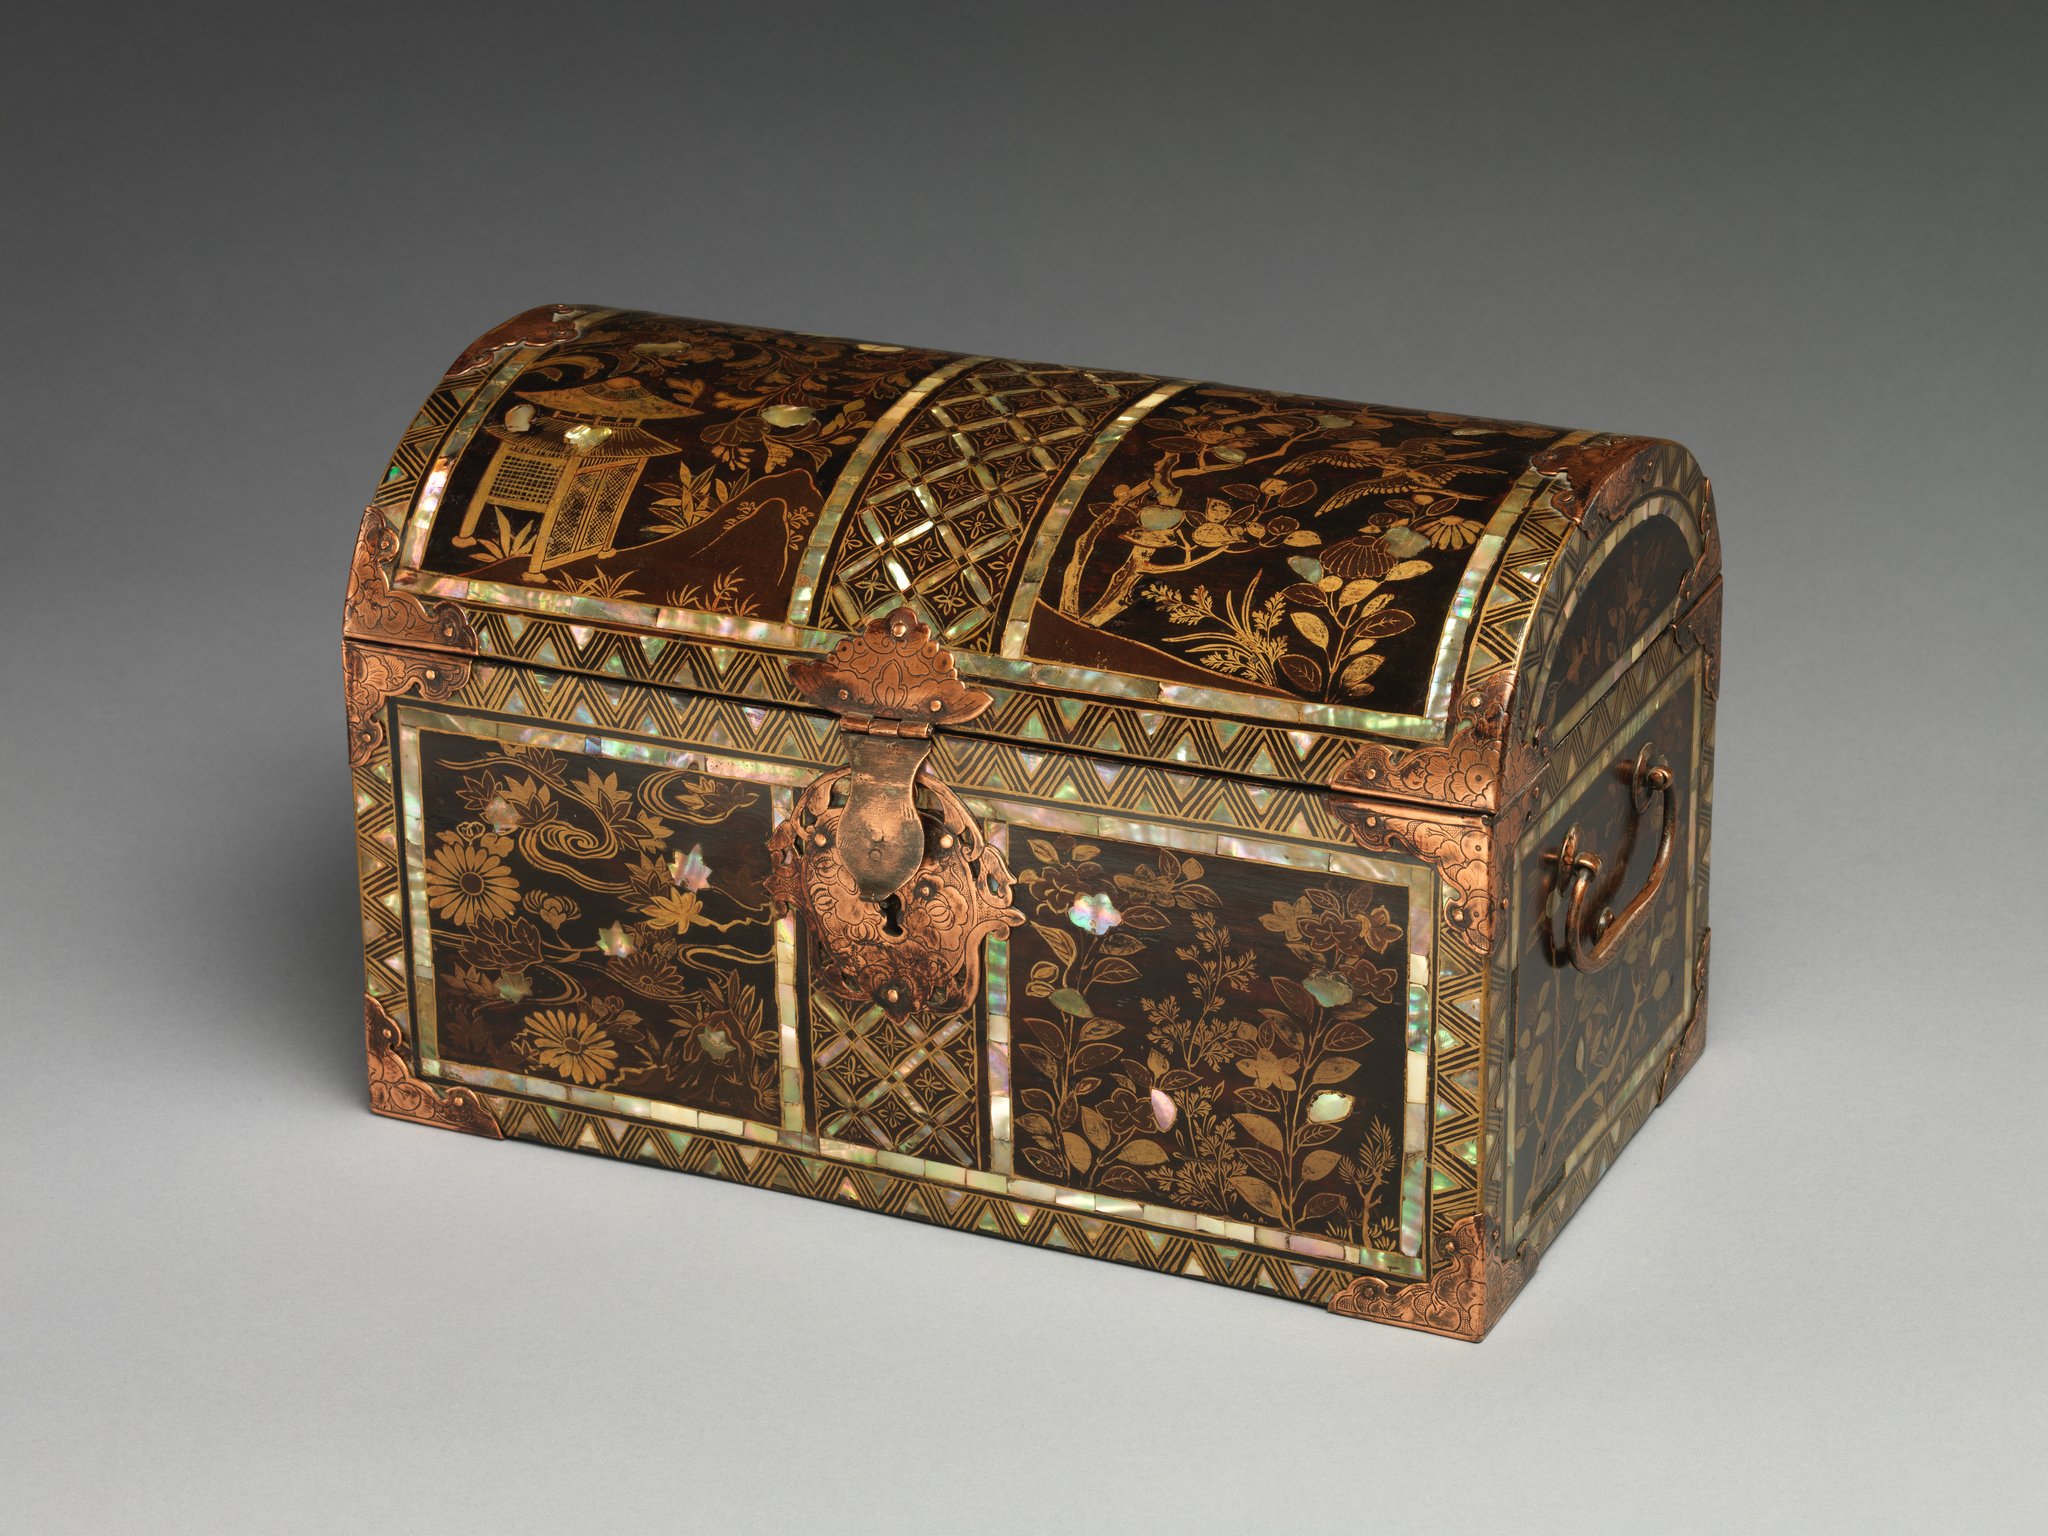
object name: coffer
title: Coffer in Nanban (Southern Barbarian) Style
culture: japanese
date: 1600-1630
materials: gilt bronze, gold, lacquer, mother of pearl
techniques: inlay, maki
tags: flowers,plants,chests